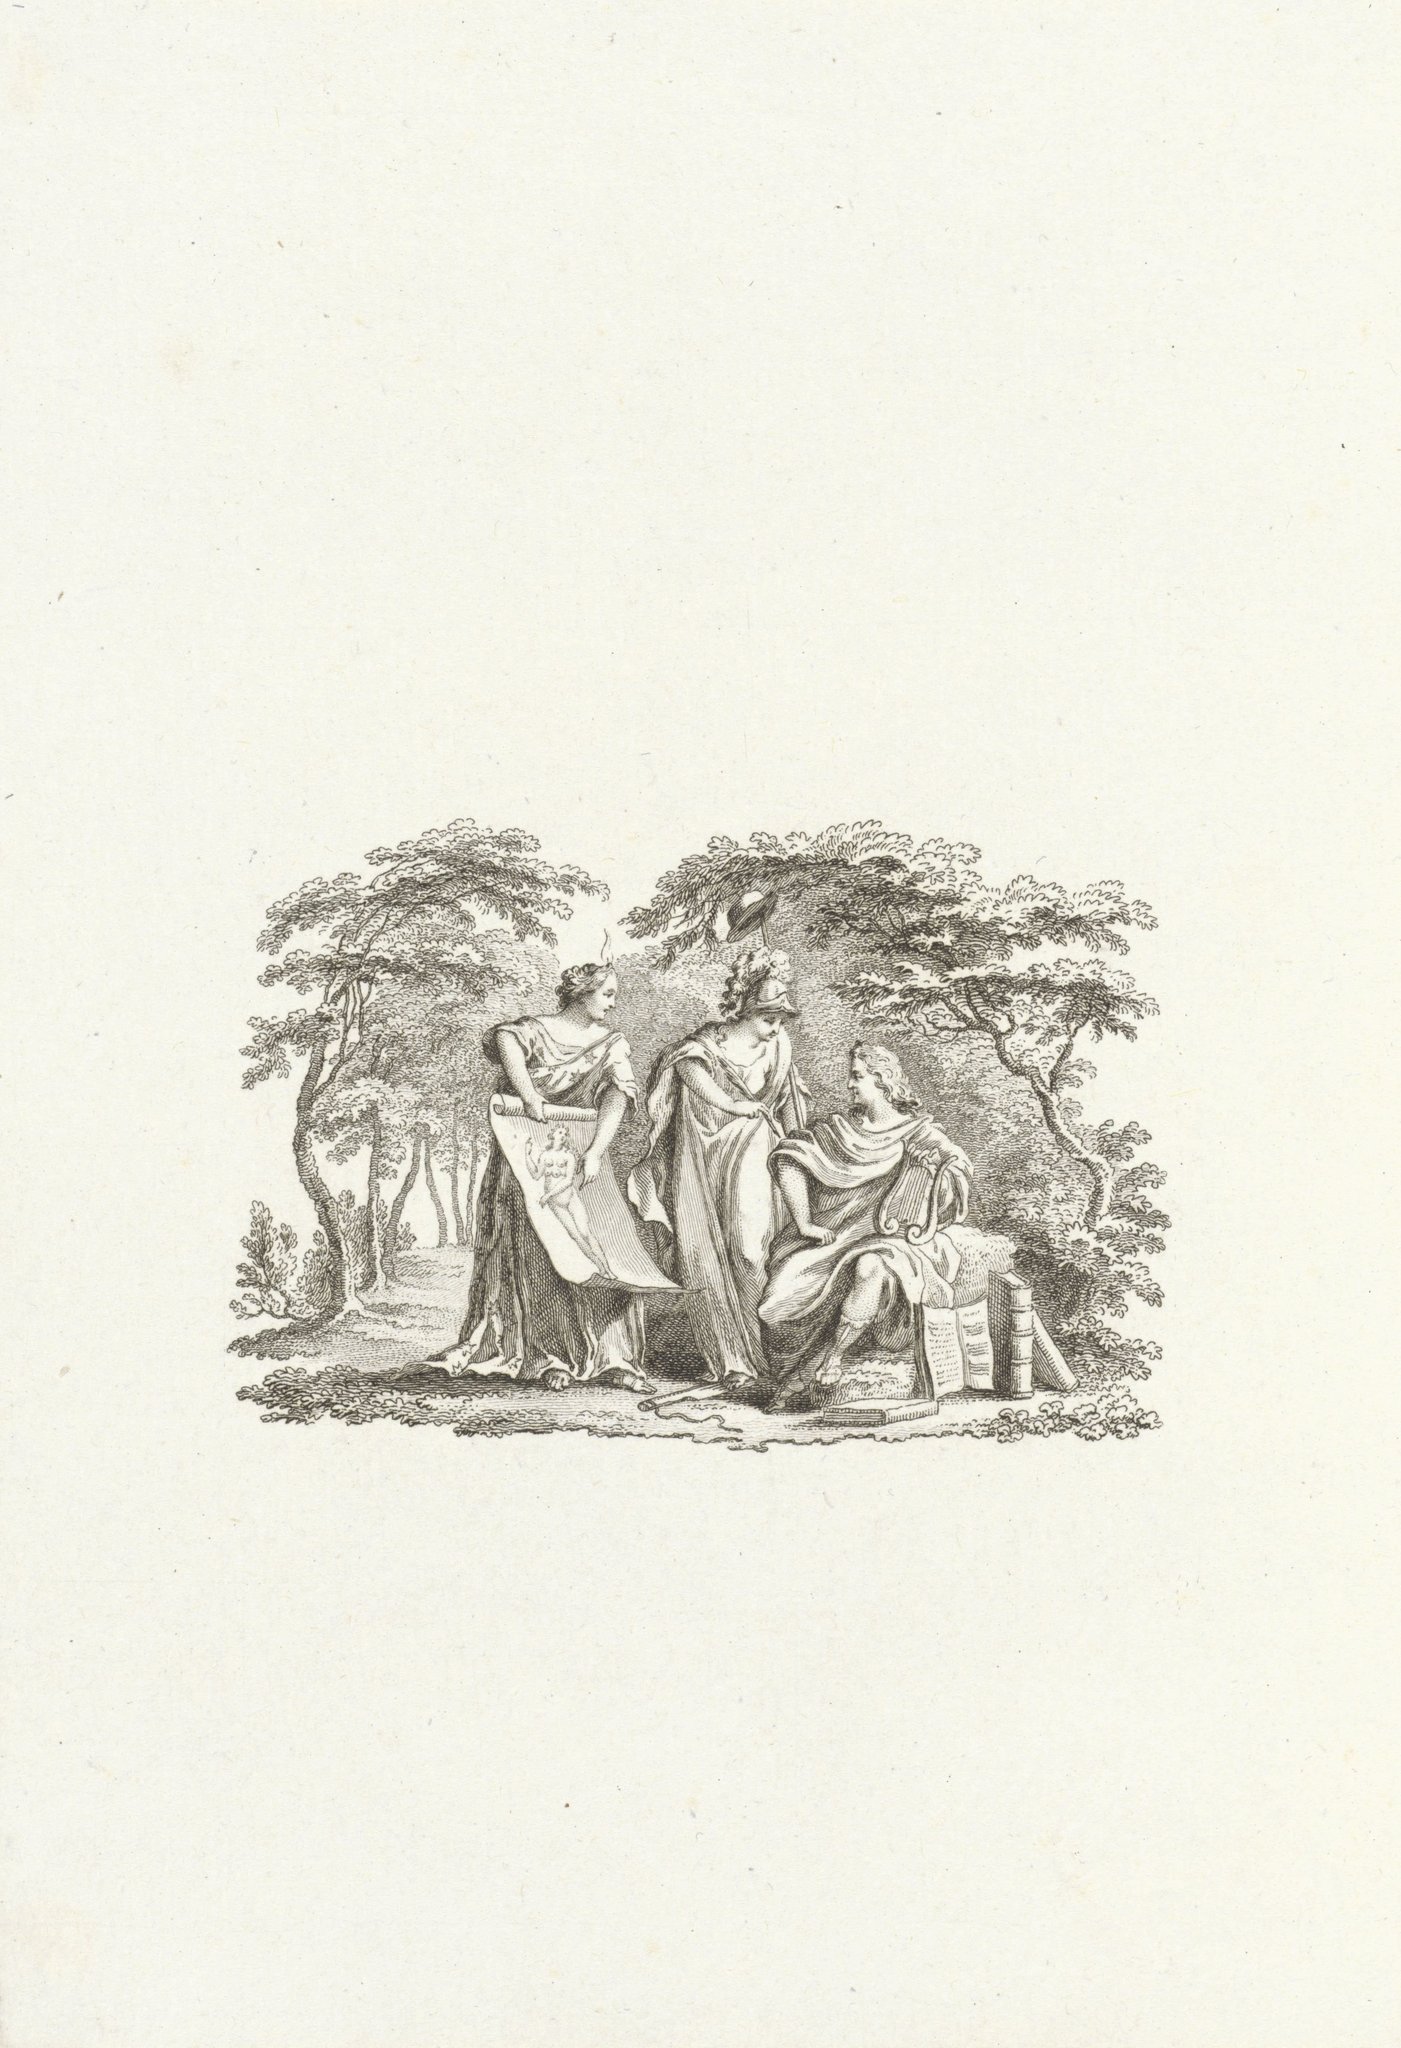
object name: print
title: Titelpagina voor: Pieter Huisinga Bakker, 'Poëzy', 1773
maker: reinier vinkeles (i)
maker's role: draughtsman, print maker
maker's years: 1741-1816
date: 1773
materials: paper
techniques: engraving, etching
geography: amsterdam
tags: symbolic representations, allegories and emblems ~ poetry; 'poesia' (ripa)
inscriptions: collector's mark: Lugt 240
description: Proefdruk van titelpagina voor: Huisinga Bakker, Pieter. Poëzy. Amsterdam: Pieter Meyer, 1773.